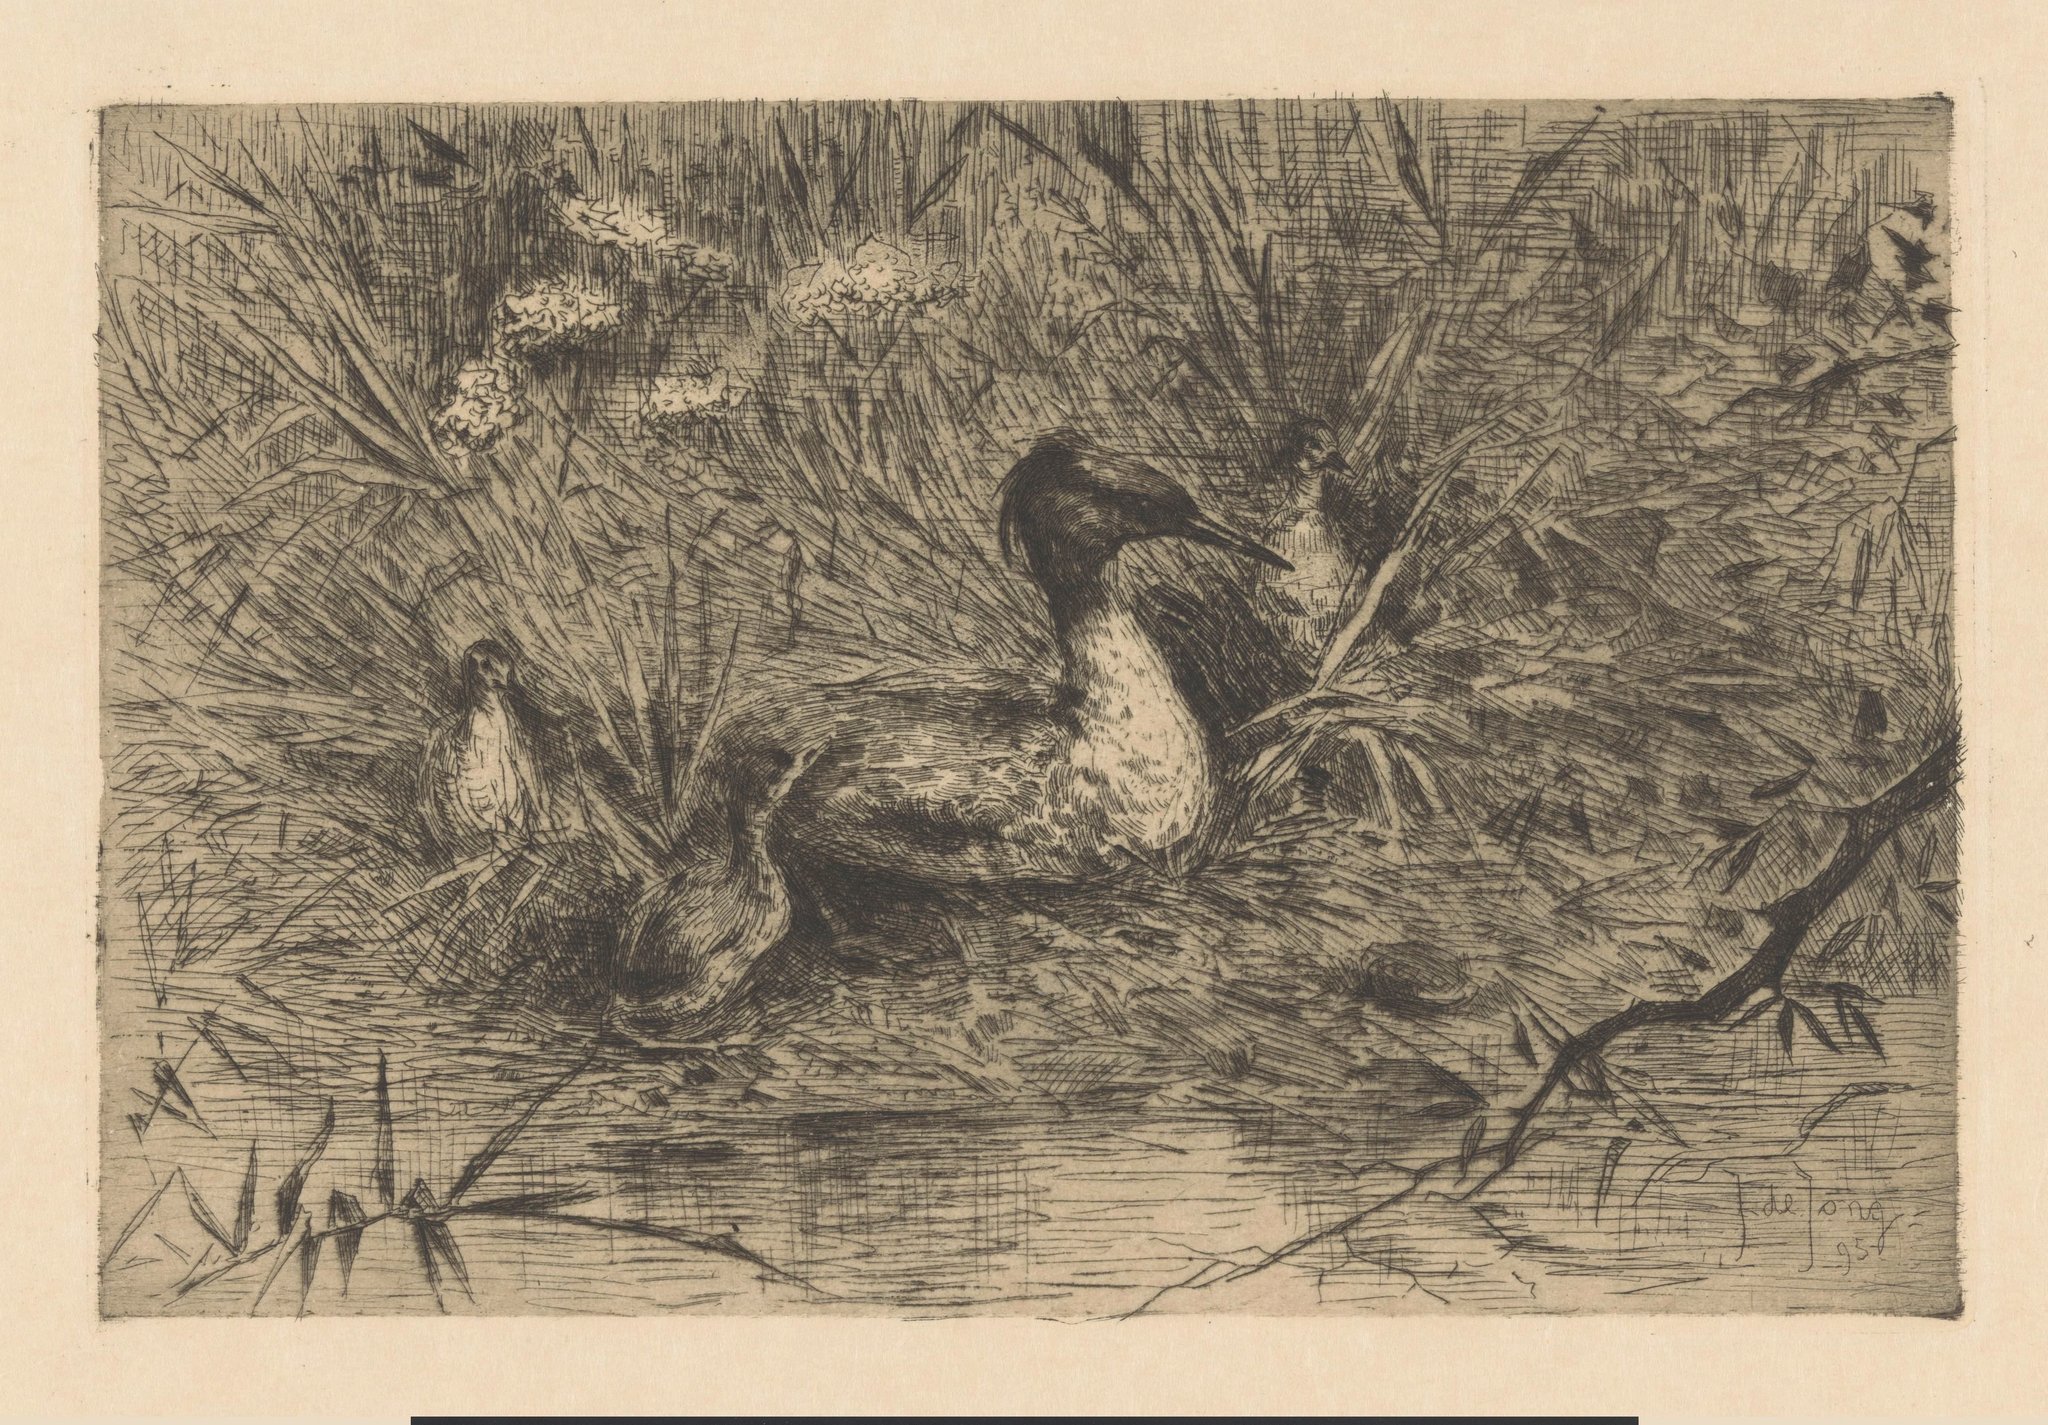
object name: print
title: Nest van een roerdomp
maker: jan de jong (1864-1901)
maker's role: draughtsman, print maker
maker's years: 1864-1901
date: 1895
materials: paper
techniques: etching, intaglio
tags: water-birds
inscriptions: collector's mark: Lugt 2228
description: Bij het nest lopen drie jonge watervogels.